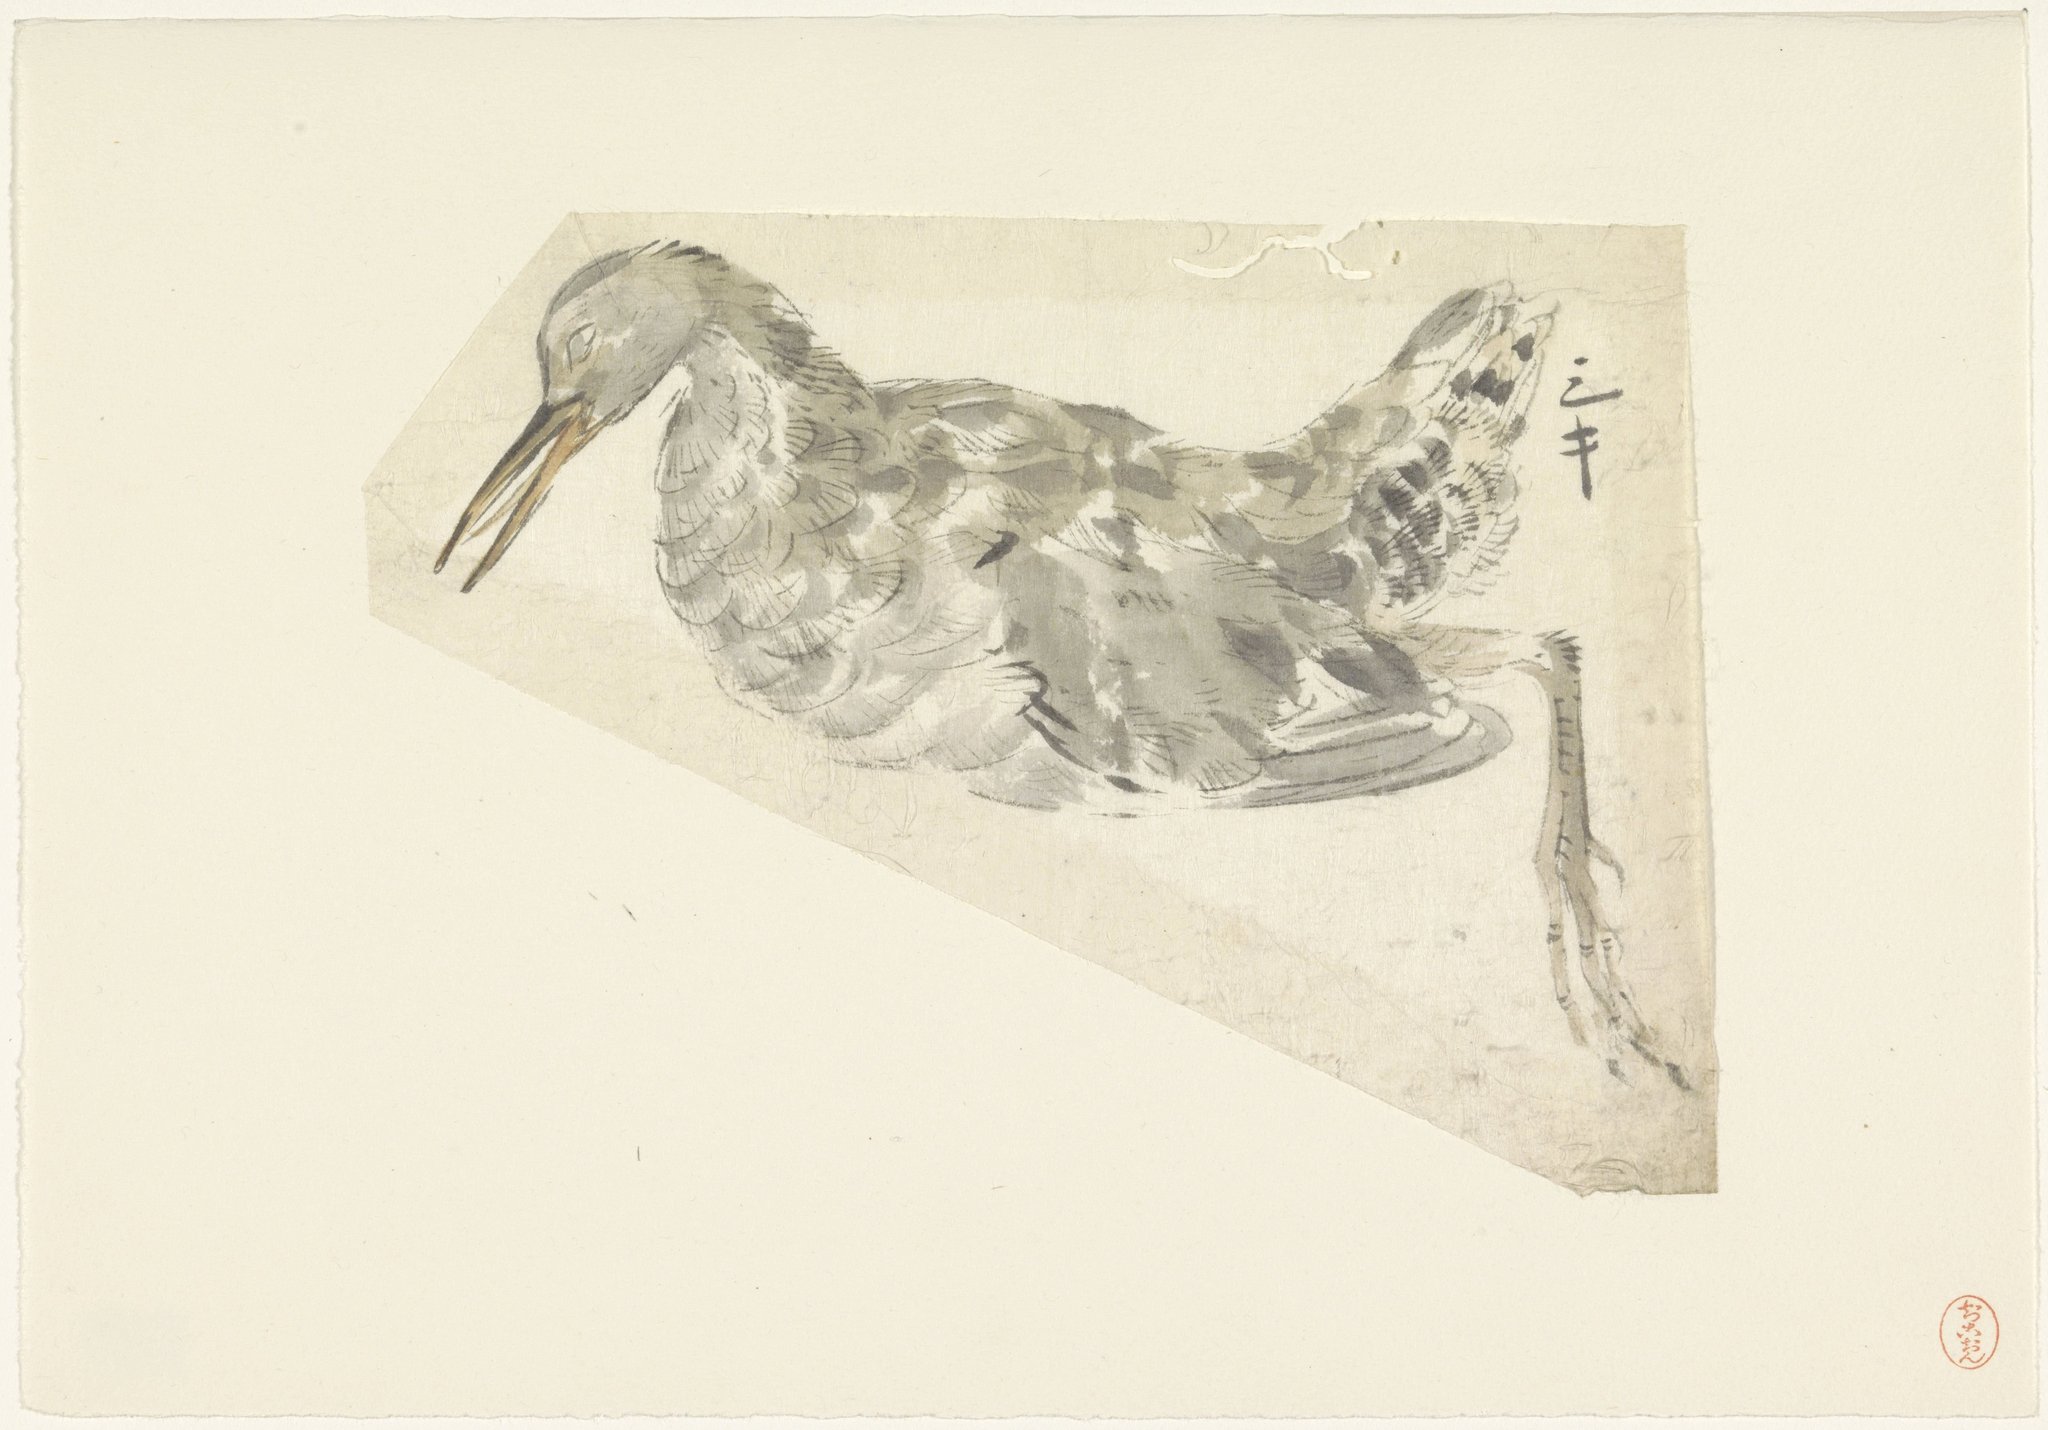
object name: drawing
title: Dode watervogel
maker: yamamoto shinryo baiitsu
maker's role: draughtsman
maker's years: 1789-1857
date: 1800-1900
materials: paper, watercolor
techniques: brush